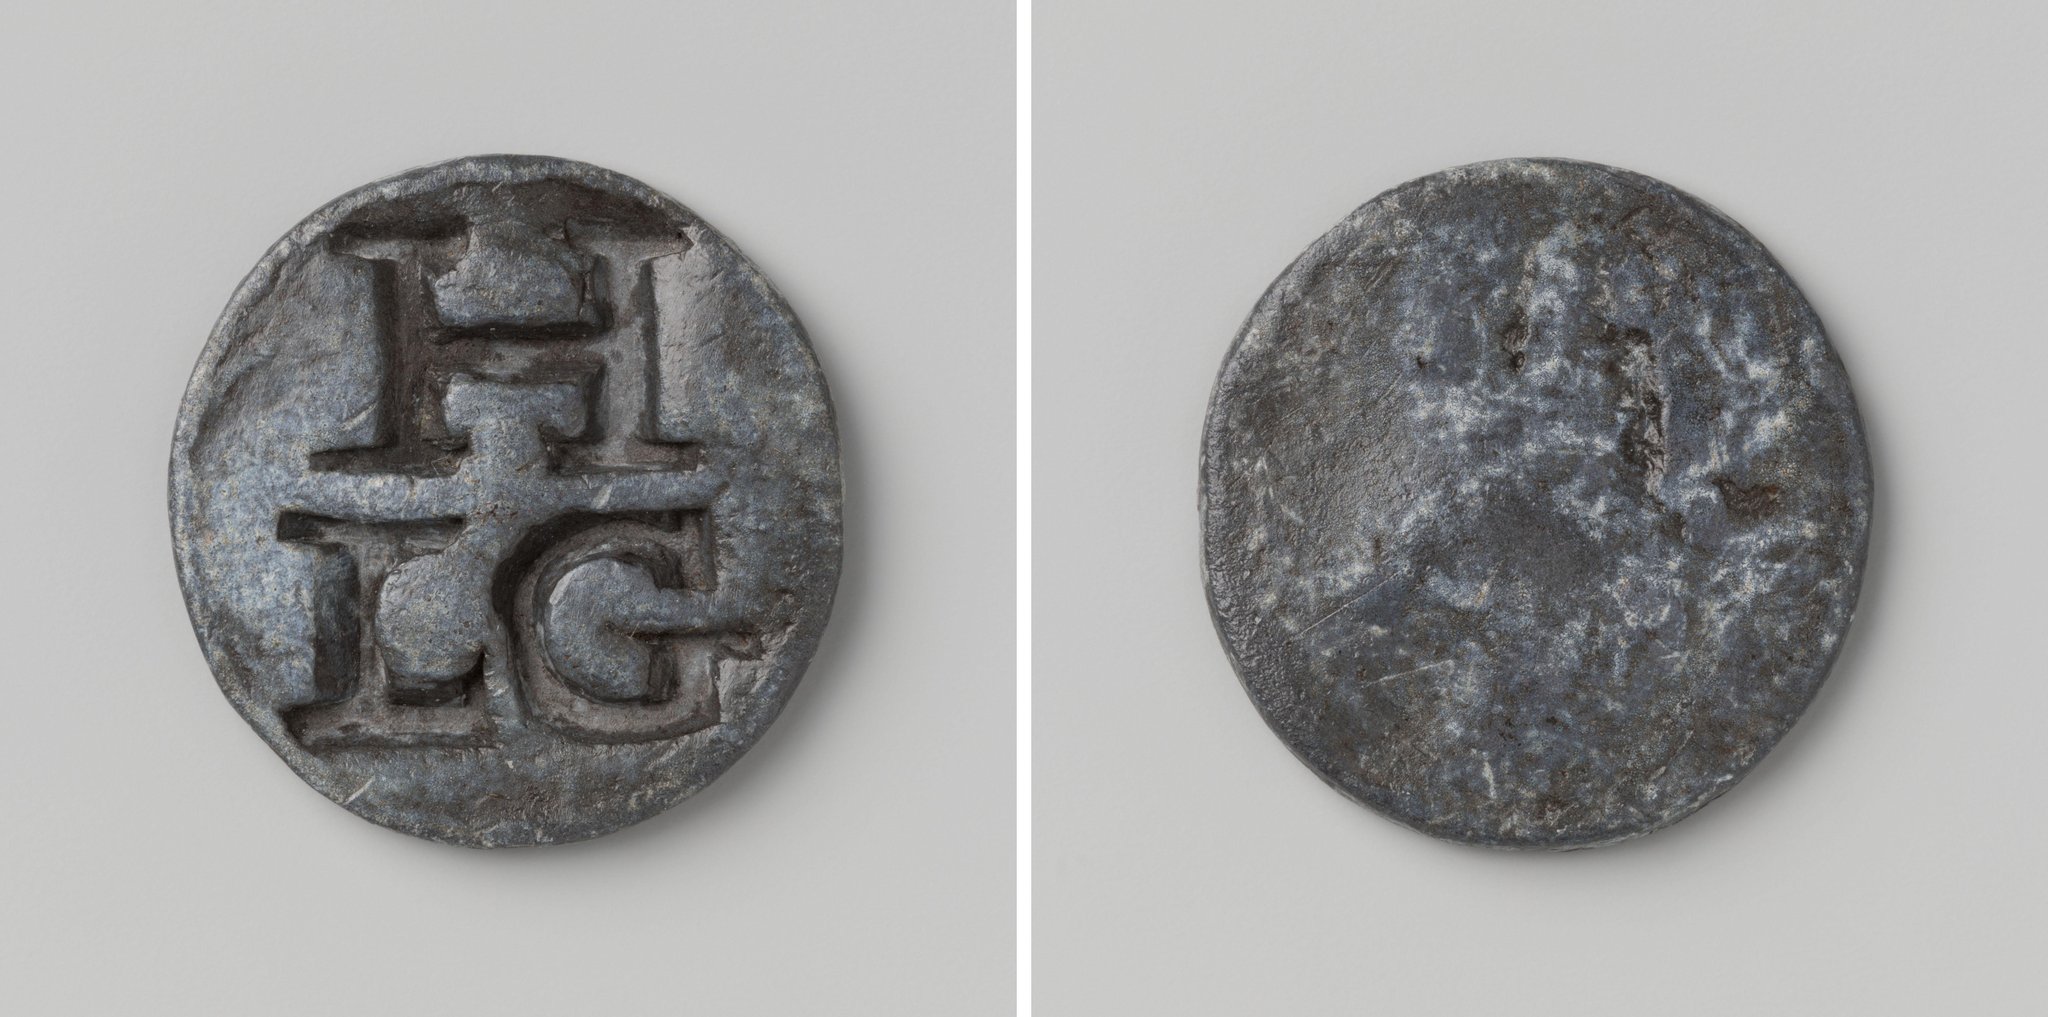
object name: communion token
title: Hersteld Lutherse Gemeente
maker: Anonymous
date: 1790-1850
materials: lead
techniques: casting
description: Eenzijdige loden penning. Voorzijde: letter H boven letters LG. Keerzijde: blanco.